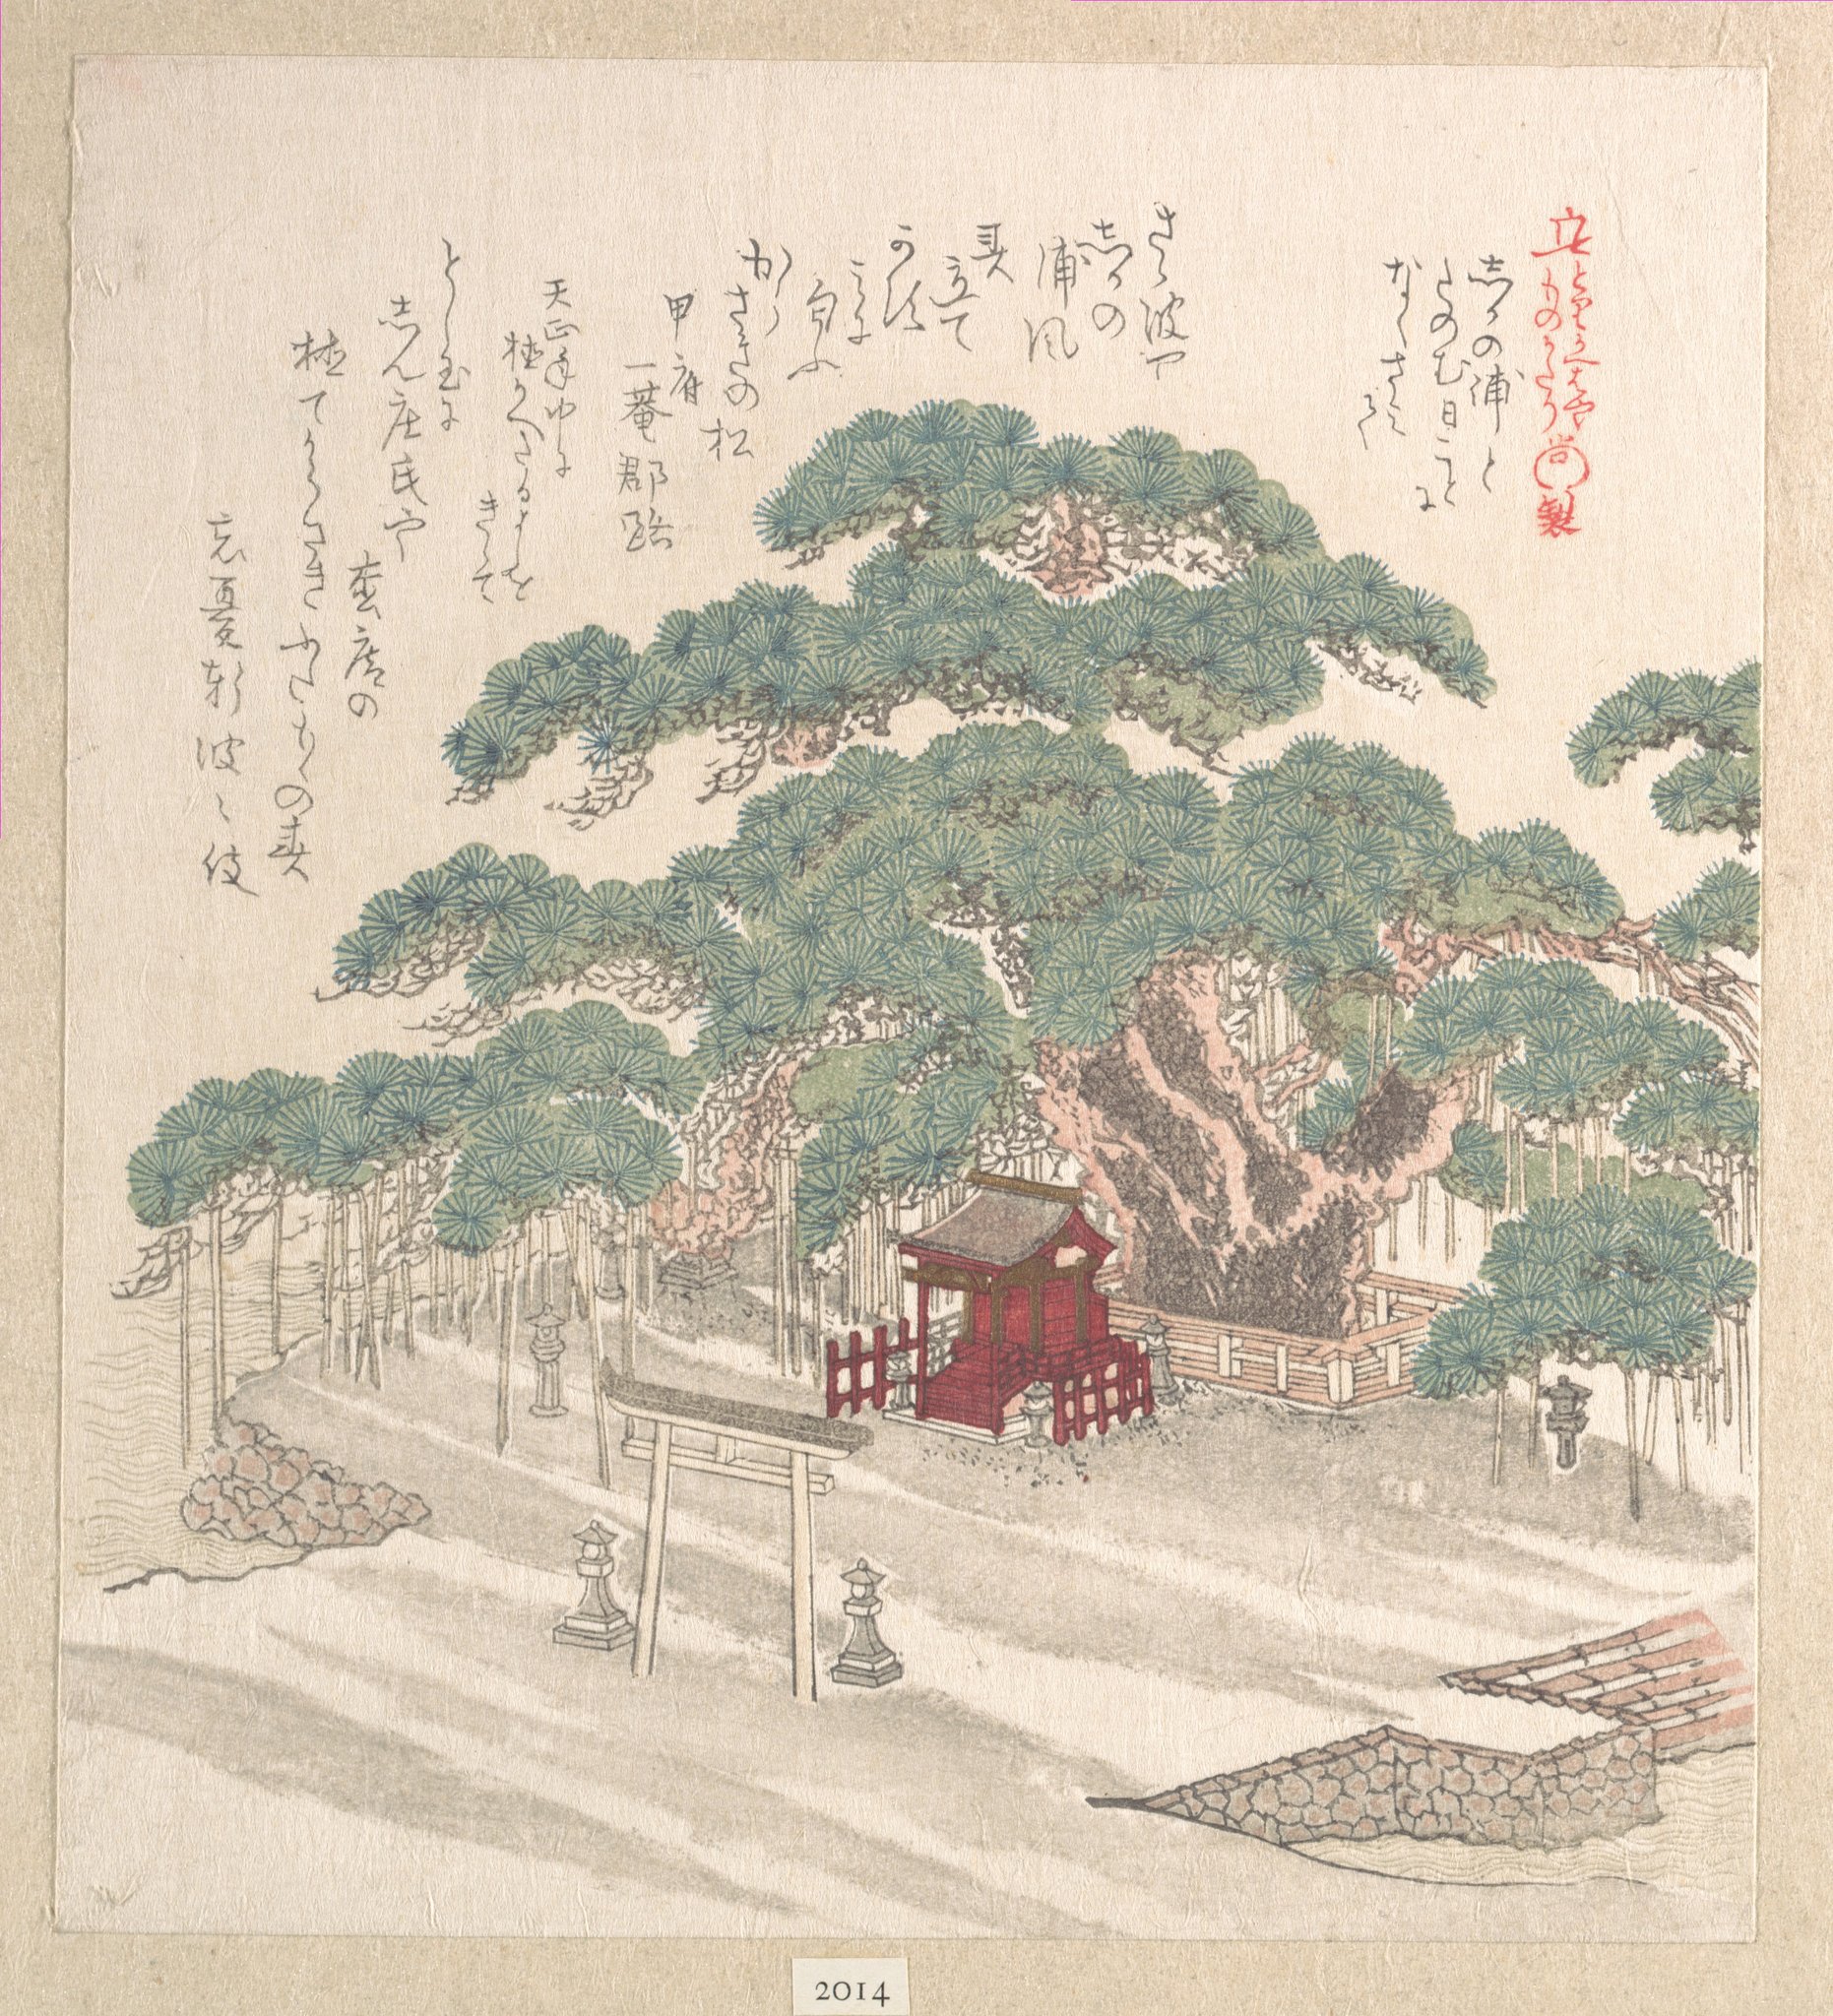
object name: print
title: Shrine Under a Big Pine Tree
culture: japanese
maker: kubo shunman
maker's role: artist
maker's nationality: japanese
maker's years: 1757-1820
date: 1801-1900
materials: ink, paper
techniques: surimono, woodblock print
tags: trees,shintō